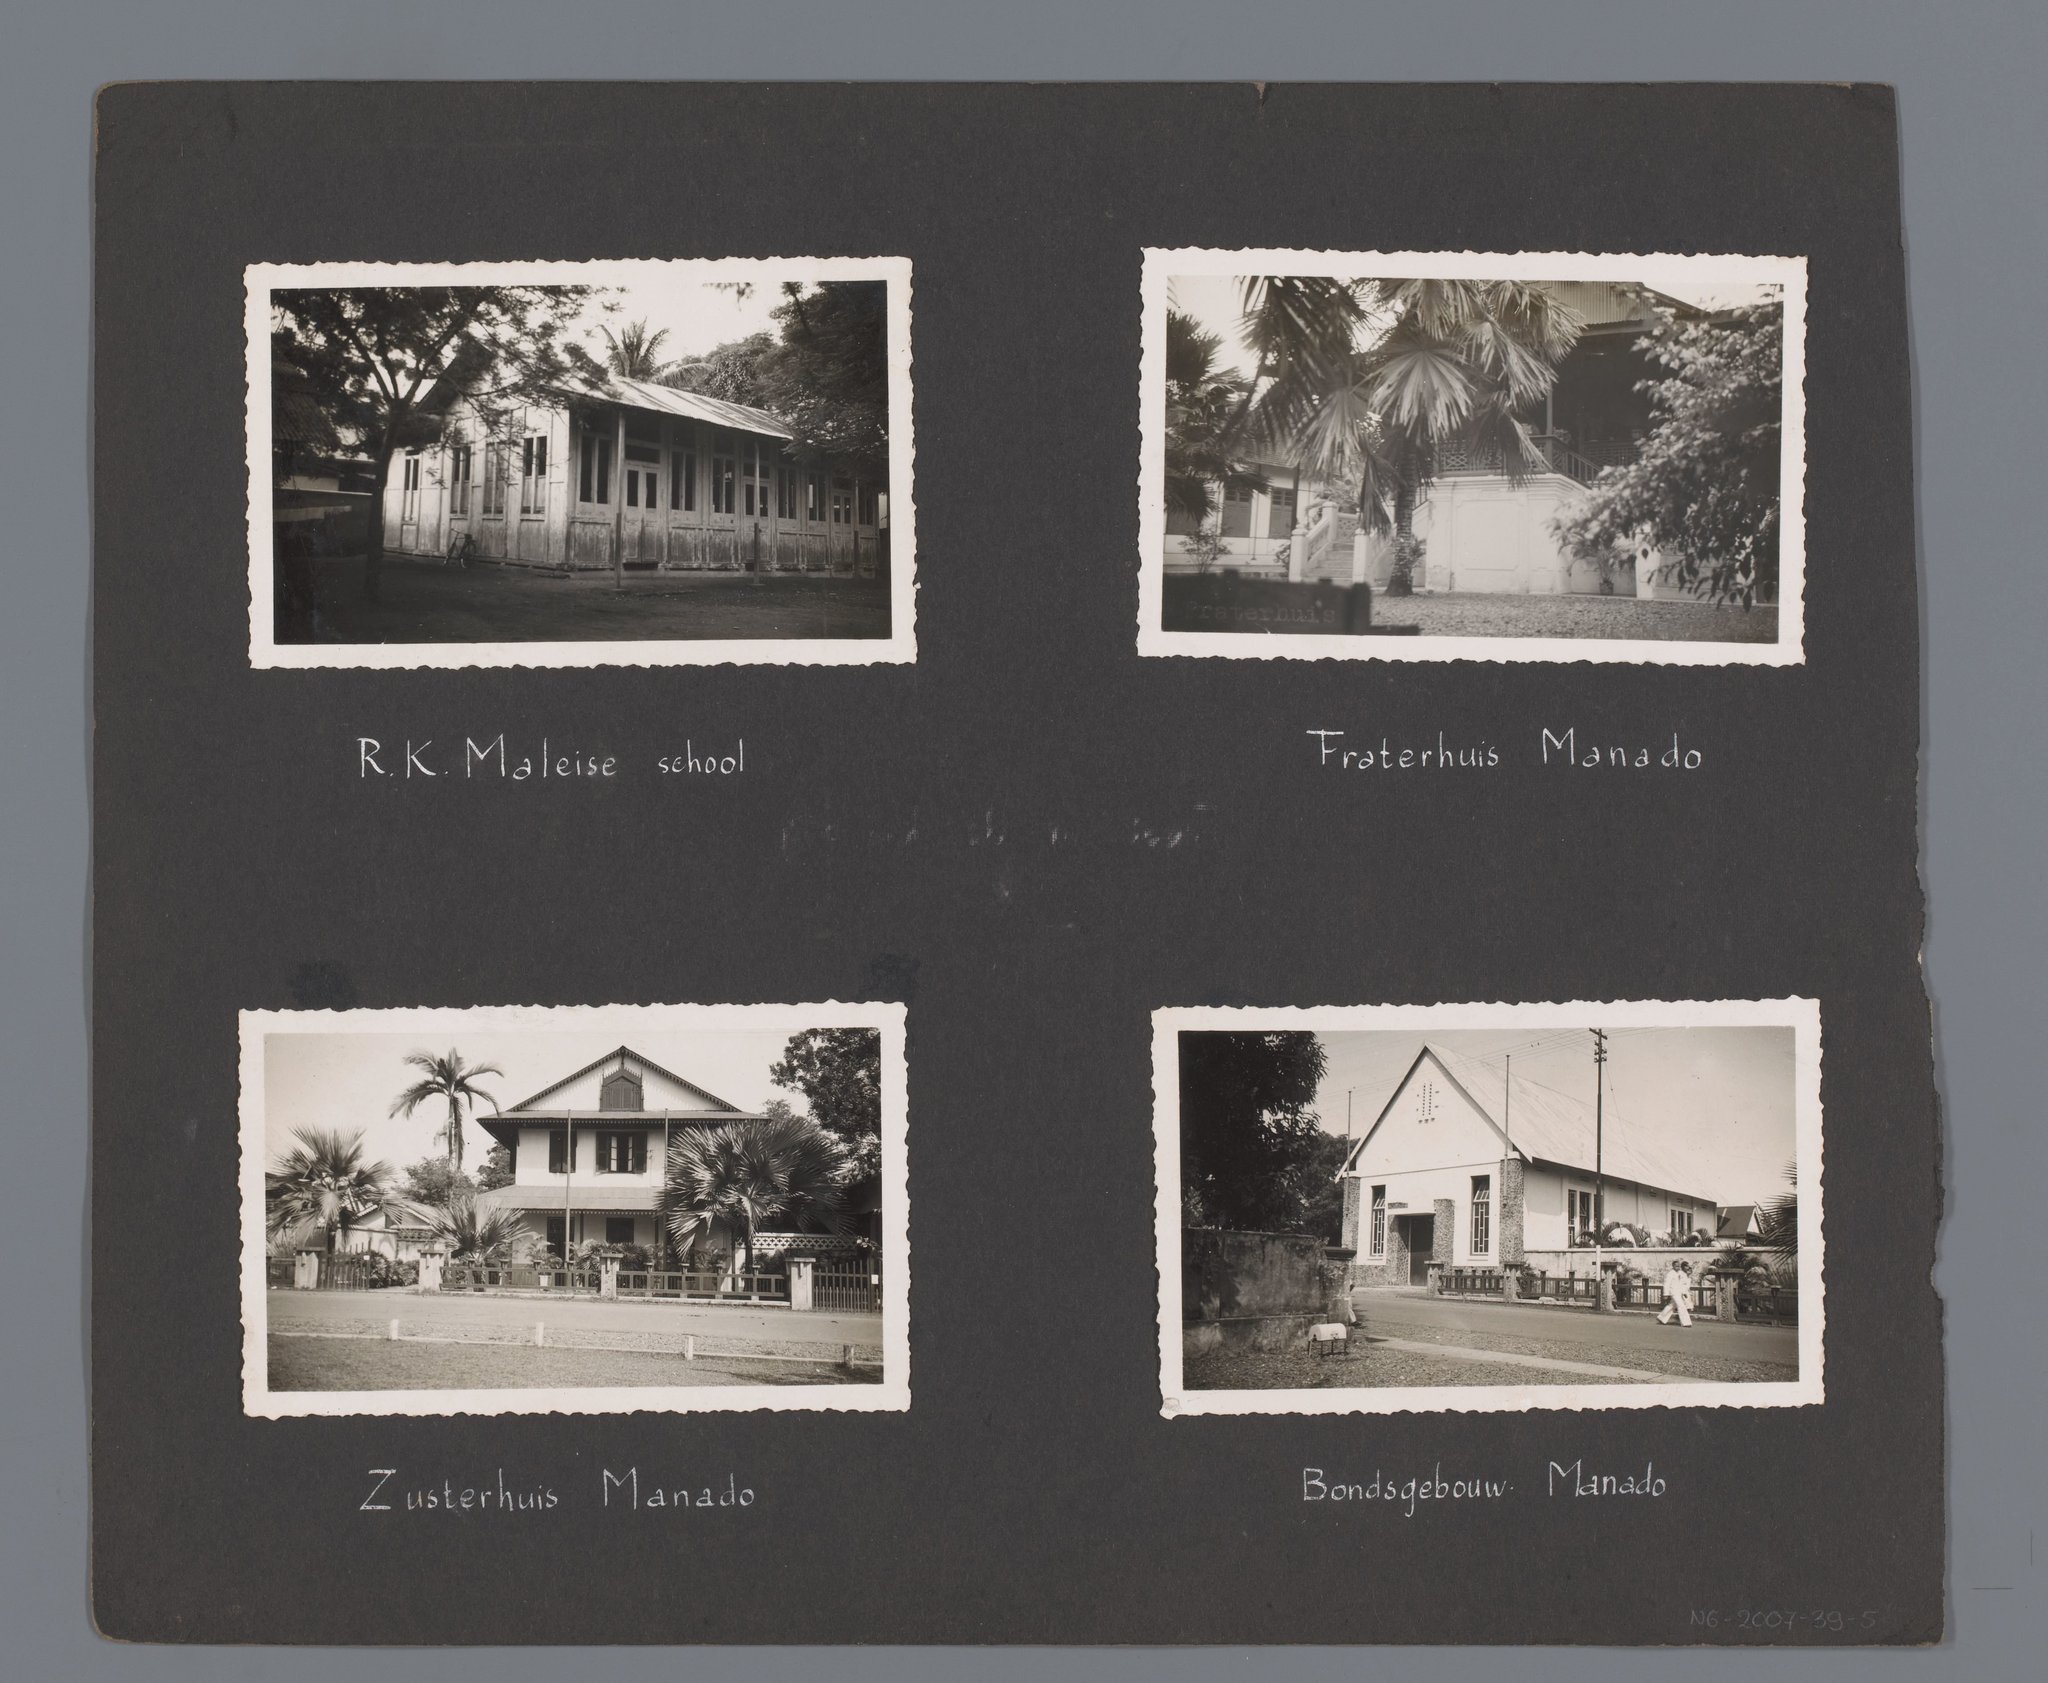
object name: photograph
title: R.K. Maleise school / Fraterhuis Manado / Zusterhuis Manado / Bondsgebouw Manado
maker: Anonymous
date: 1930-1939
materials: paper, photographic support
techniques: photography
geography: celebes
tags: fraters van tilburg, manado, celebes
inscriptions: annotation: ‘R.K. Maleise school / Fraterhuis Manado / Zusterhuis Manado / Bondsgebouw Manado’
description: Het noorden van Celebes (Sulawesi) wordt wel aangeduid als de Minahassa, met als grootste stad Manado. In september 1924 vestigden de eerste twee Fraters van Tilburg zich in Manado, Zij zouden hier uiteindelijk een groot terrein op de Kema-weg betrekken en een Chinese school met internaat en een MULO stichten.